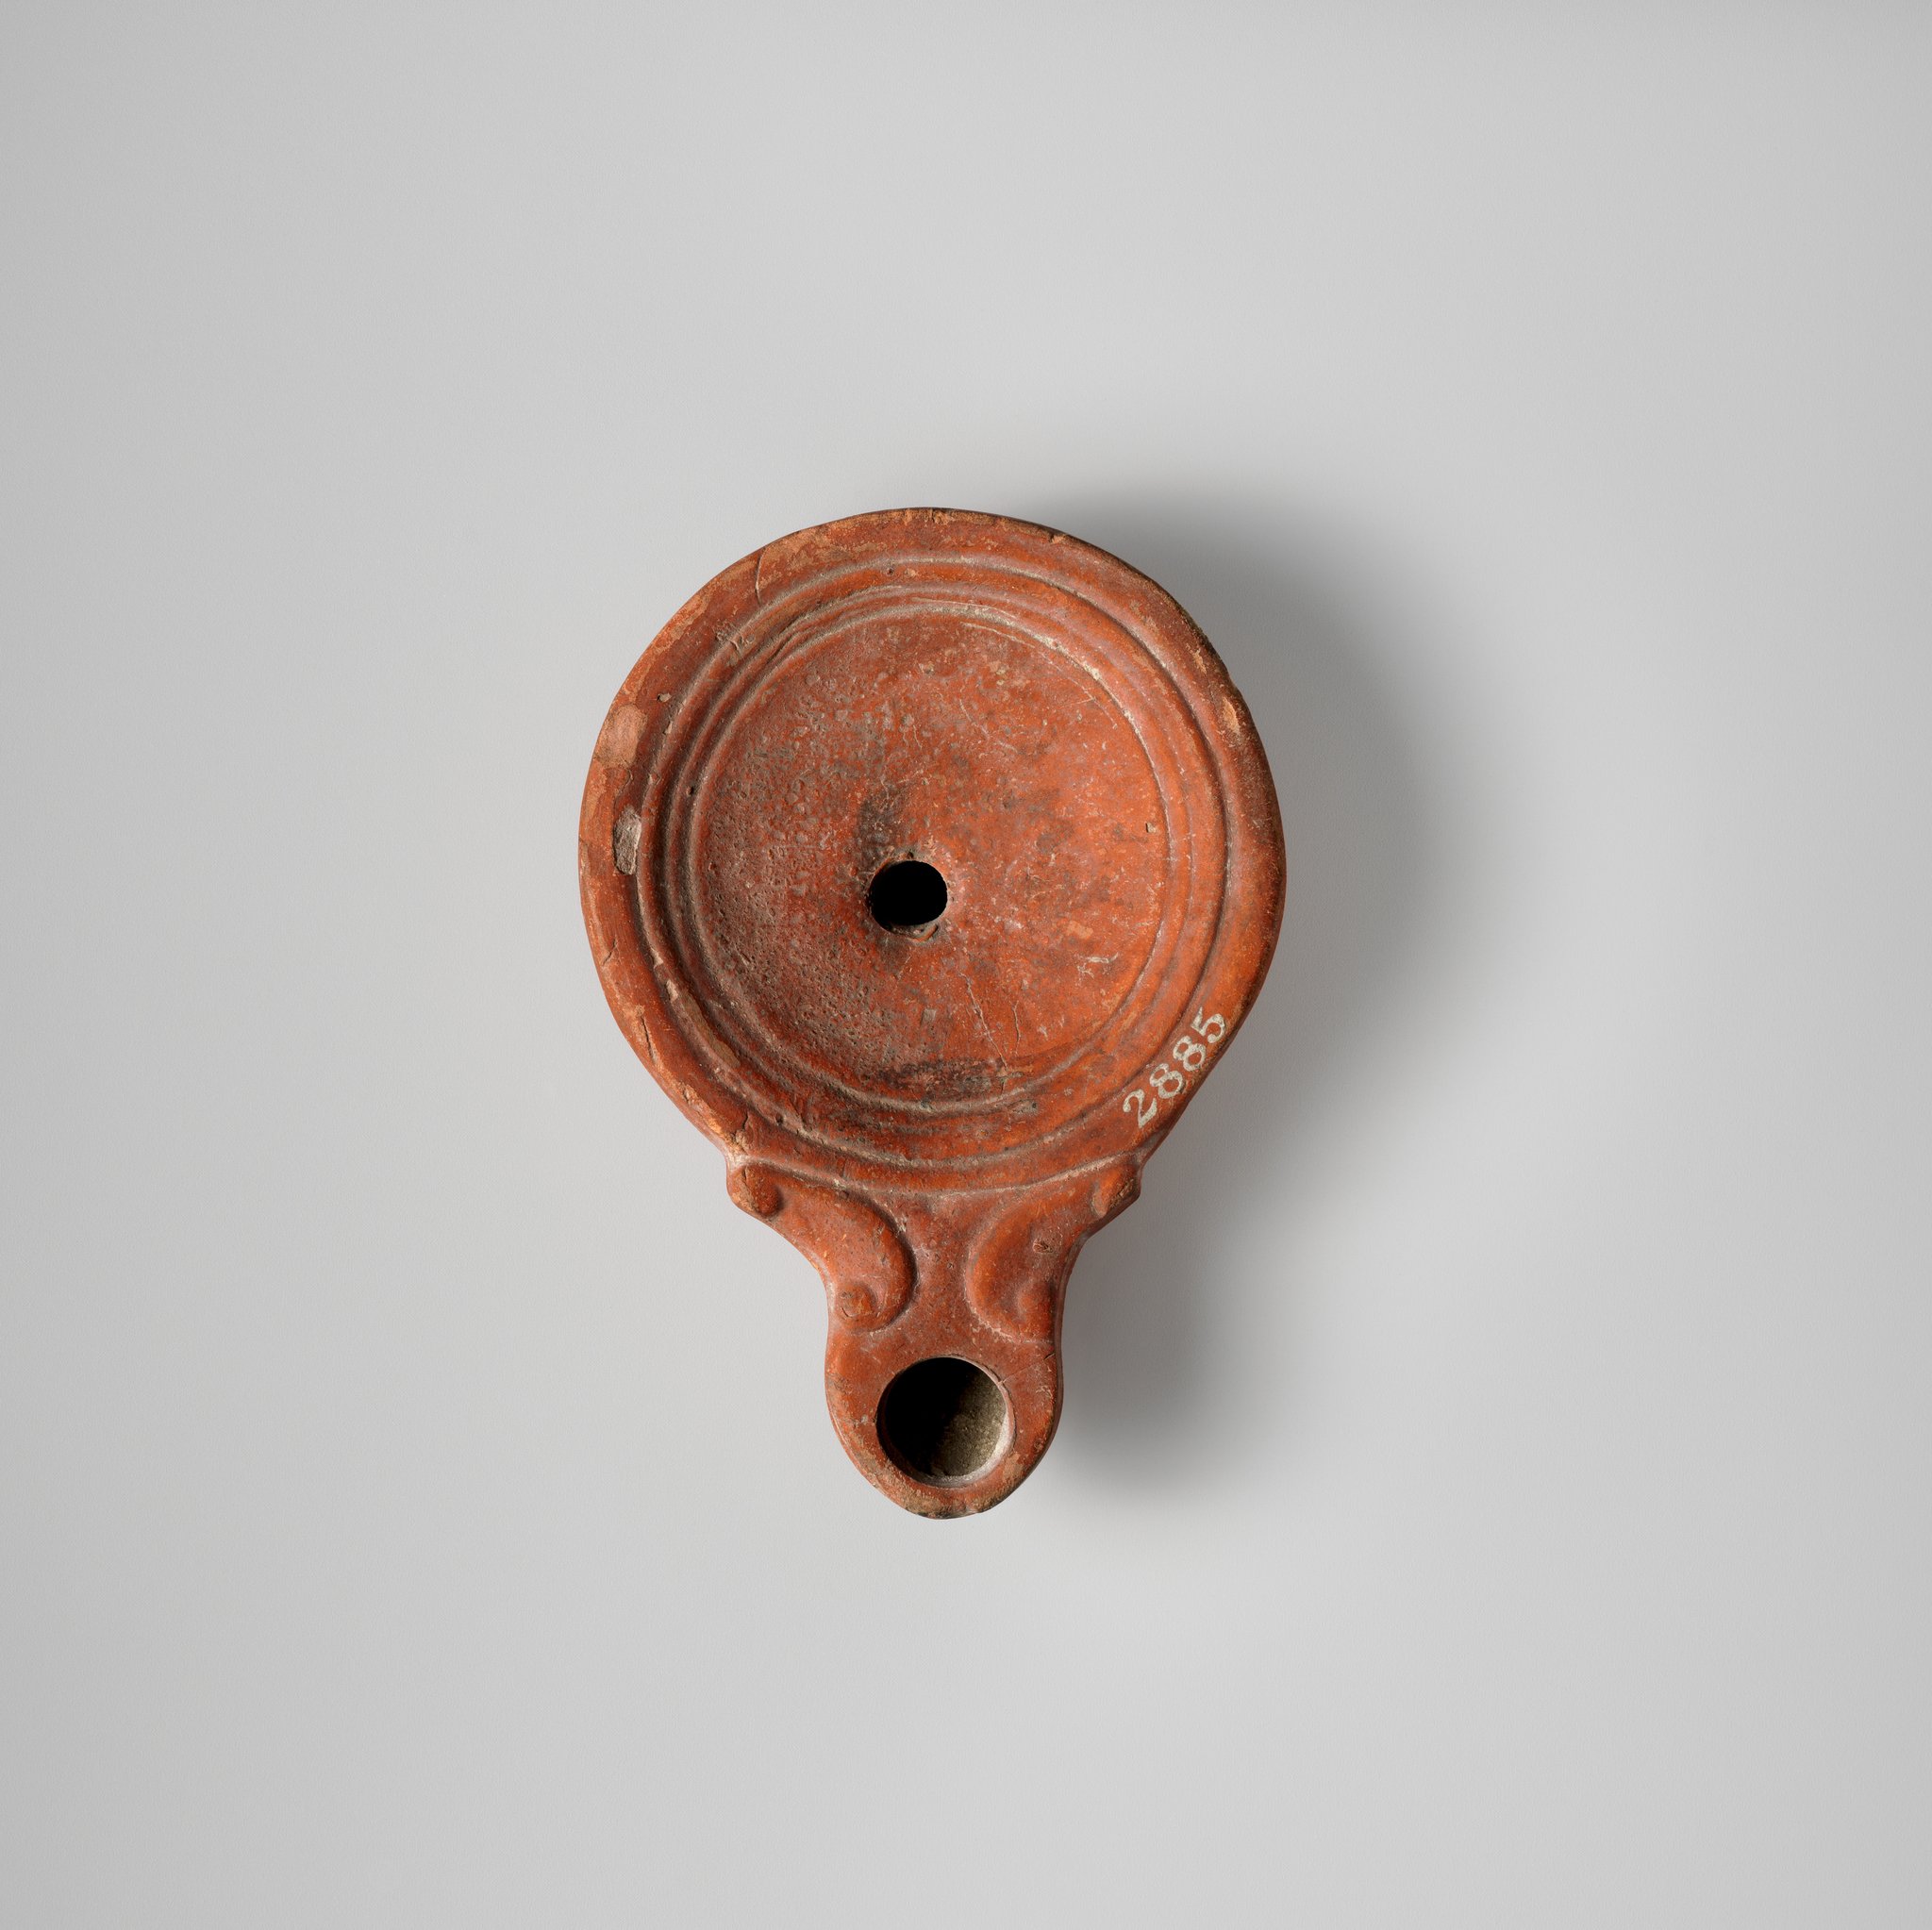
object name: lamp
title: Terracotta oil lamp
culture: roman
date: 100 BCE-100 CE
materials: terracotta